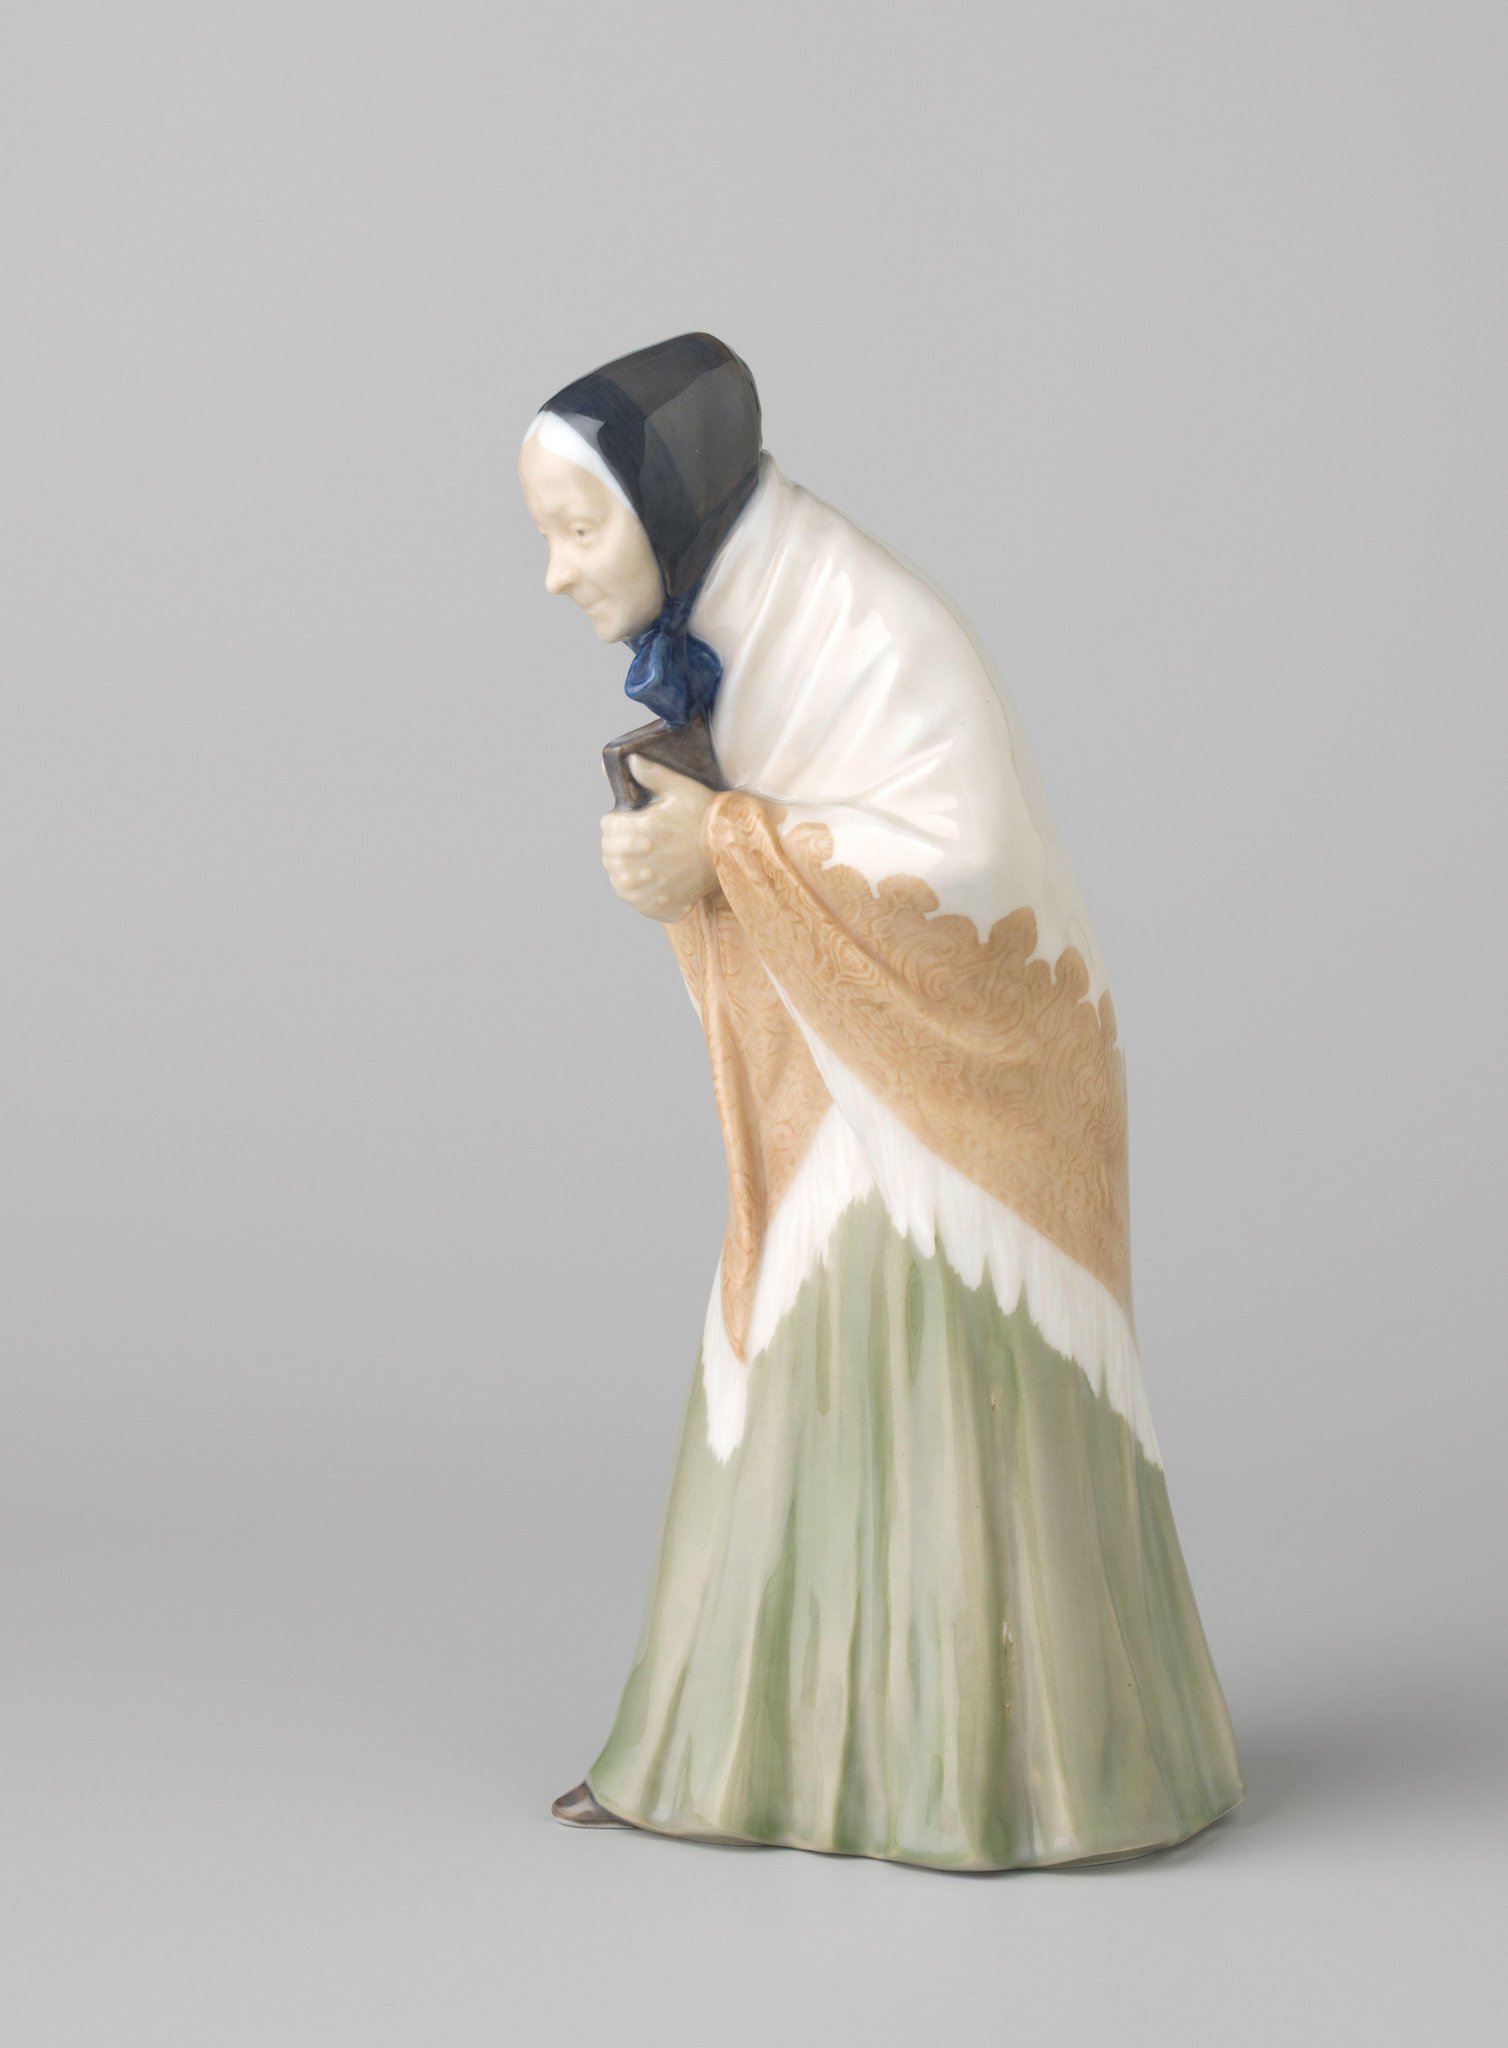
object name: decoratief object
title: Decoratief object van porselein in de vorm van een oude vrouw met boek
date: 1908-1913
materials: porcelain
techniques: painted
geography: copenhagen